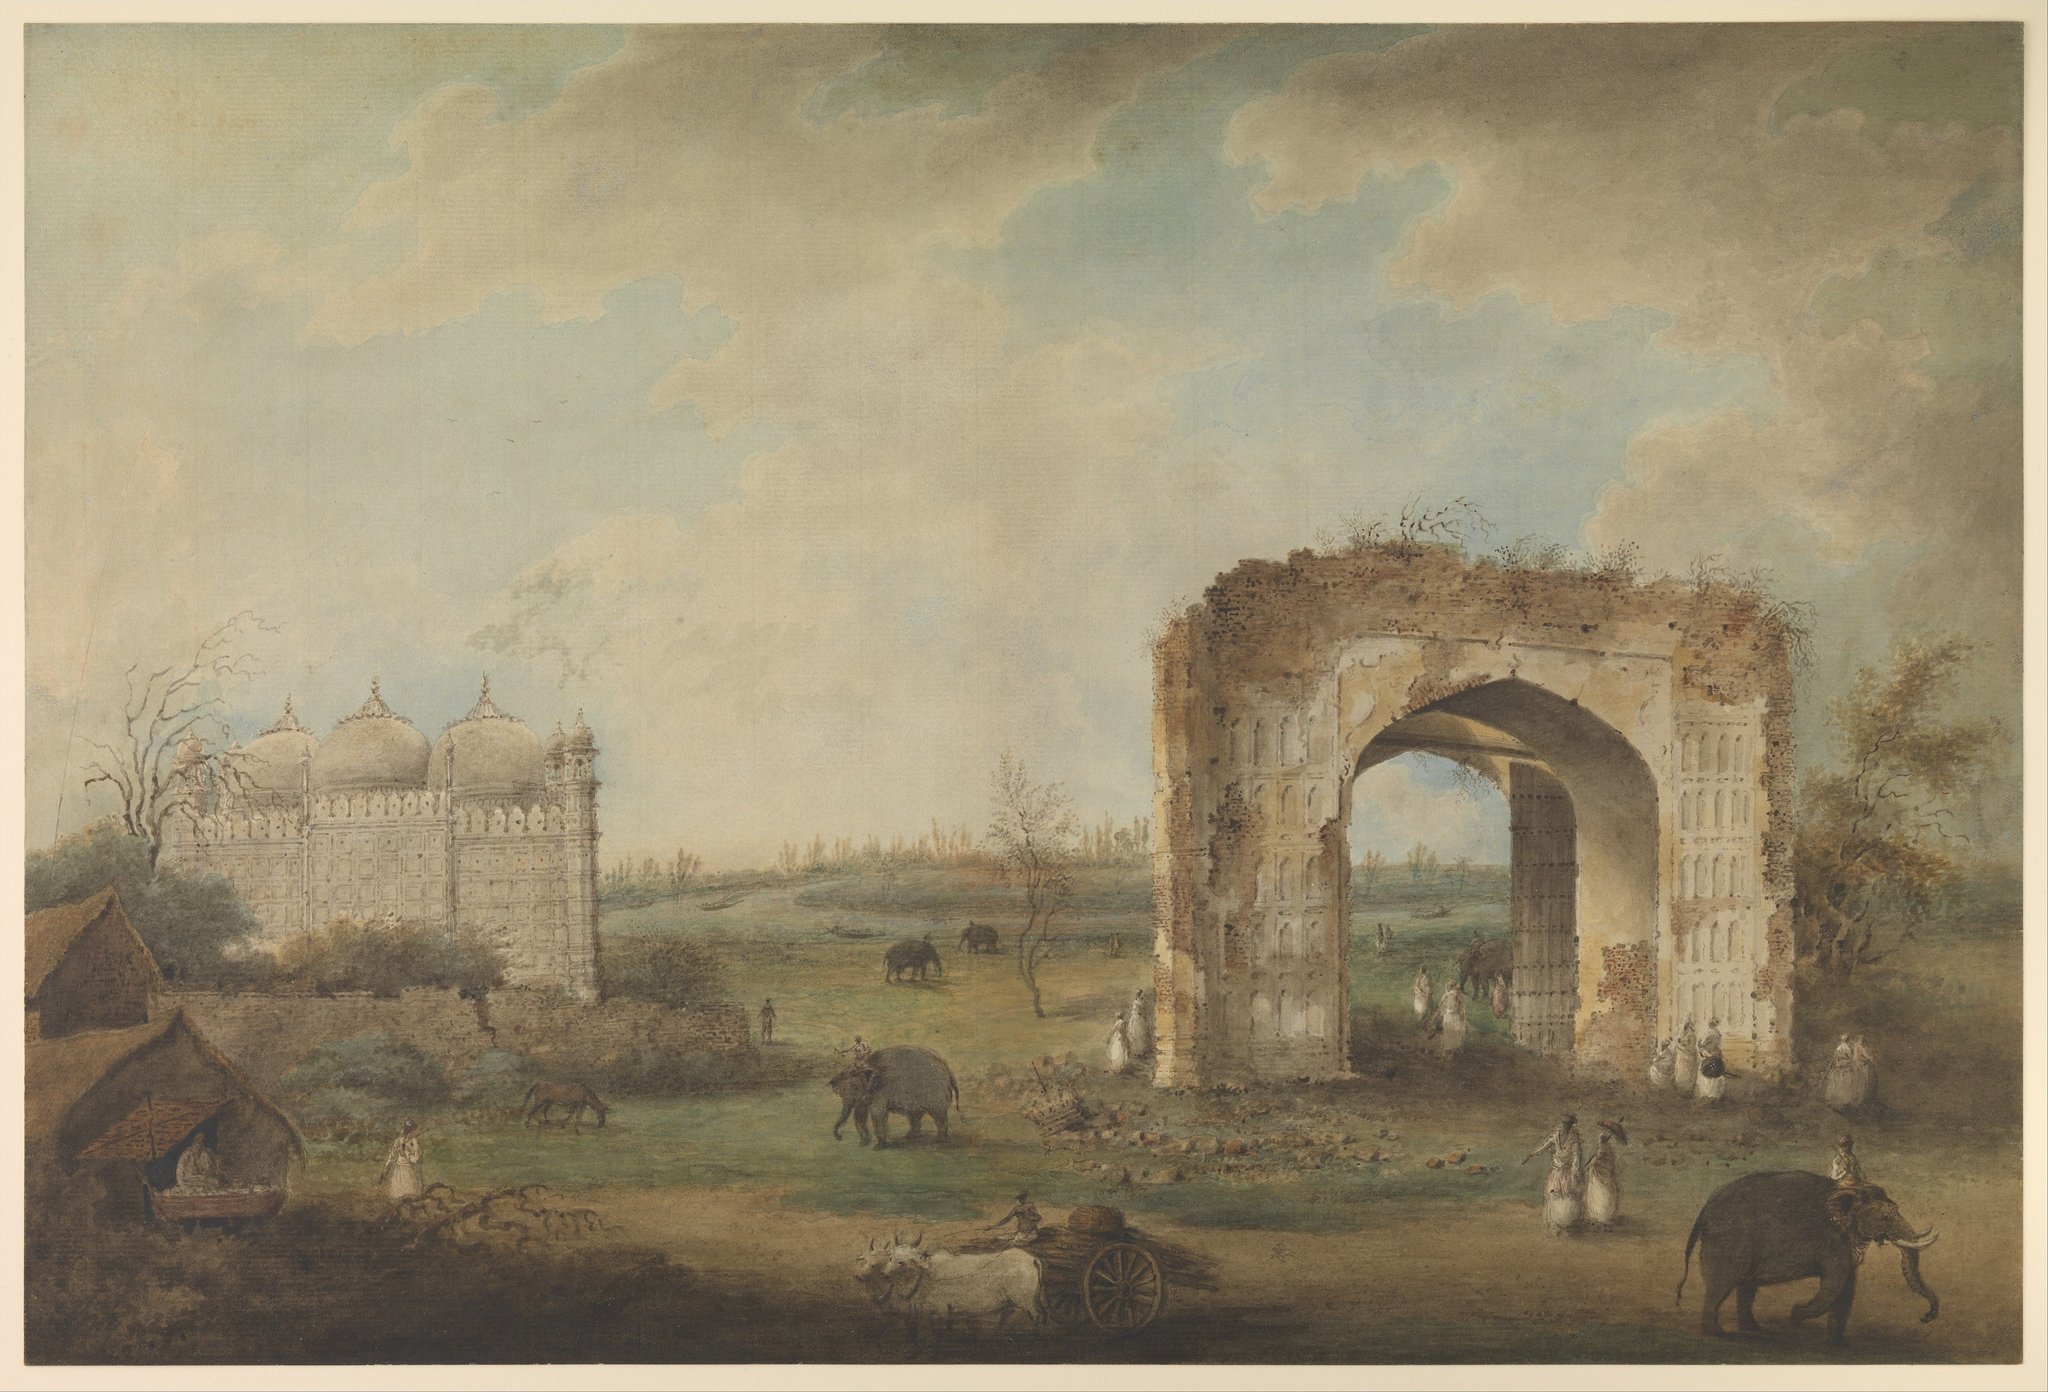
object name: illustrated single work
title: View of a Mosque and Gateway at Motijhil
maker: sita ram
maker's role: artist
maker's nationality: indian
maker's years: 1785-1847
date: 1814-1823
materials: paper, watercolor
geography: india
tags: arches,mosques,elephants